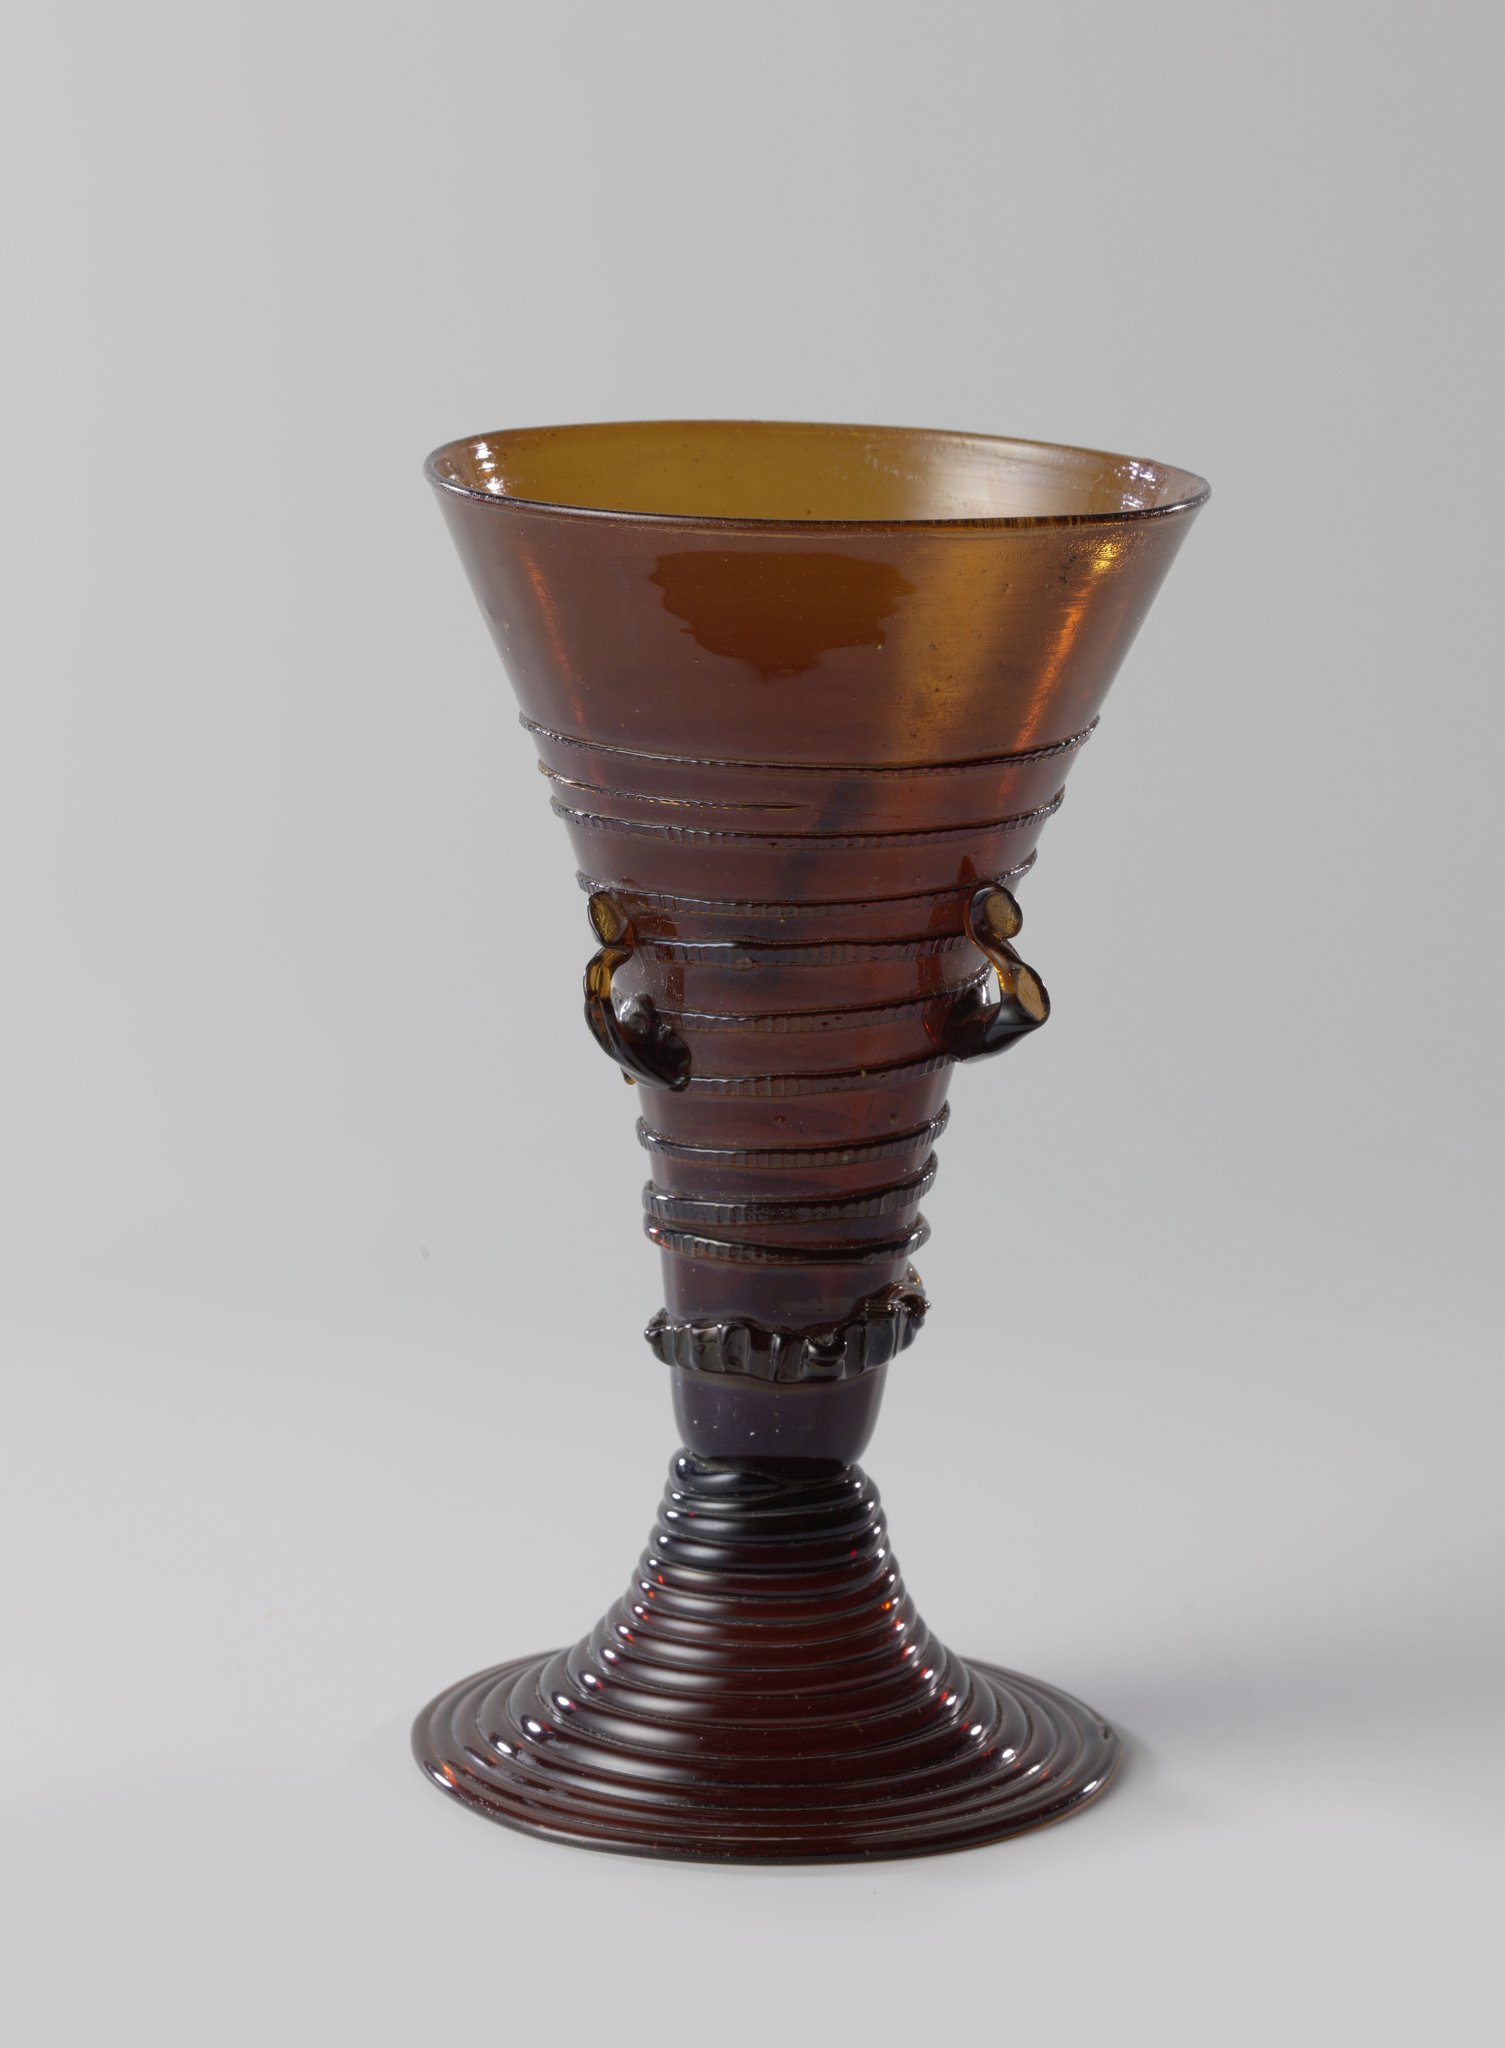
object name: ringbeker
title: Ringelbeker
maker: Anonymous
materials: glass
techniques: glassblowing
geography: germany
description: Concave, uit een draad gesponnen voet. Trechtervormige kelk, waaromheen spiraalsgewijs een geribde draad is gelegd. Halverweg de kelk drie ogen.